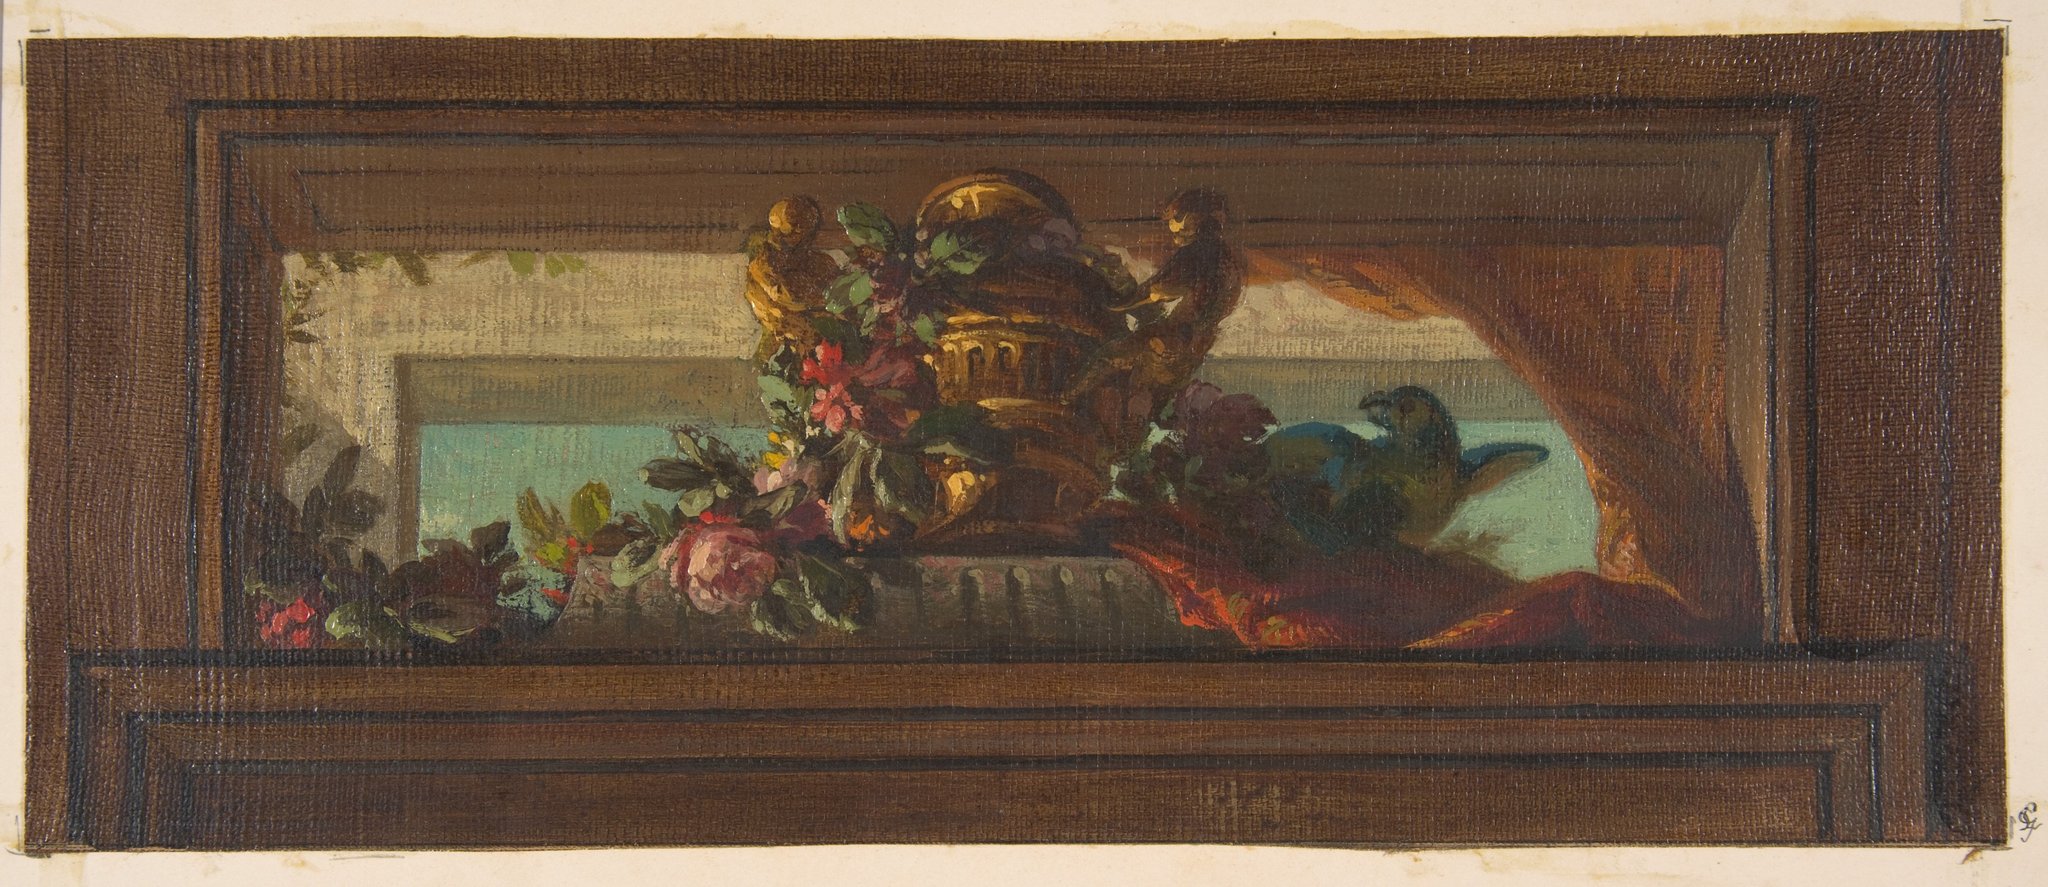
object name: drawing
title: Trompe l'oeil design of birds and flowers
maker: jules-edmond-charles lachaise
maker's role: artist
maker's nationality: french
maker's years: 1897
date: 1851-1900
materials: canvas, oil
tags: birds,flowers